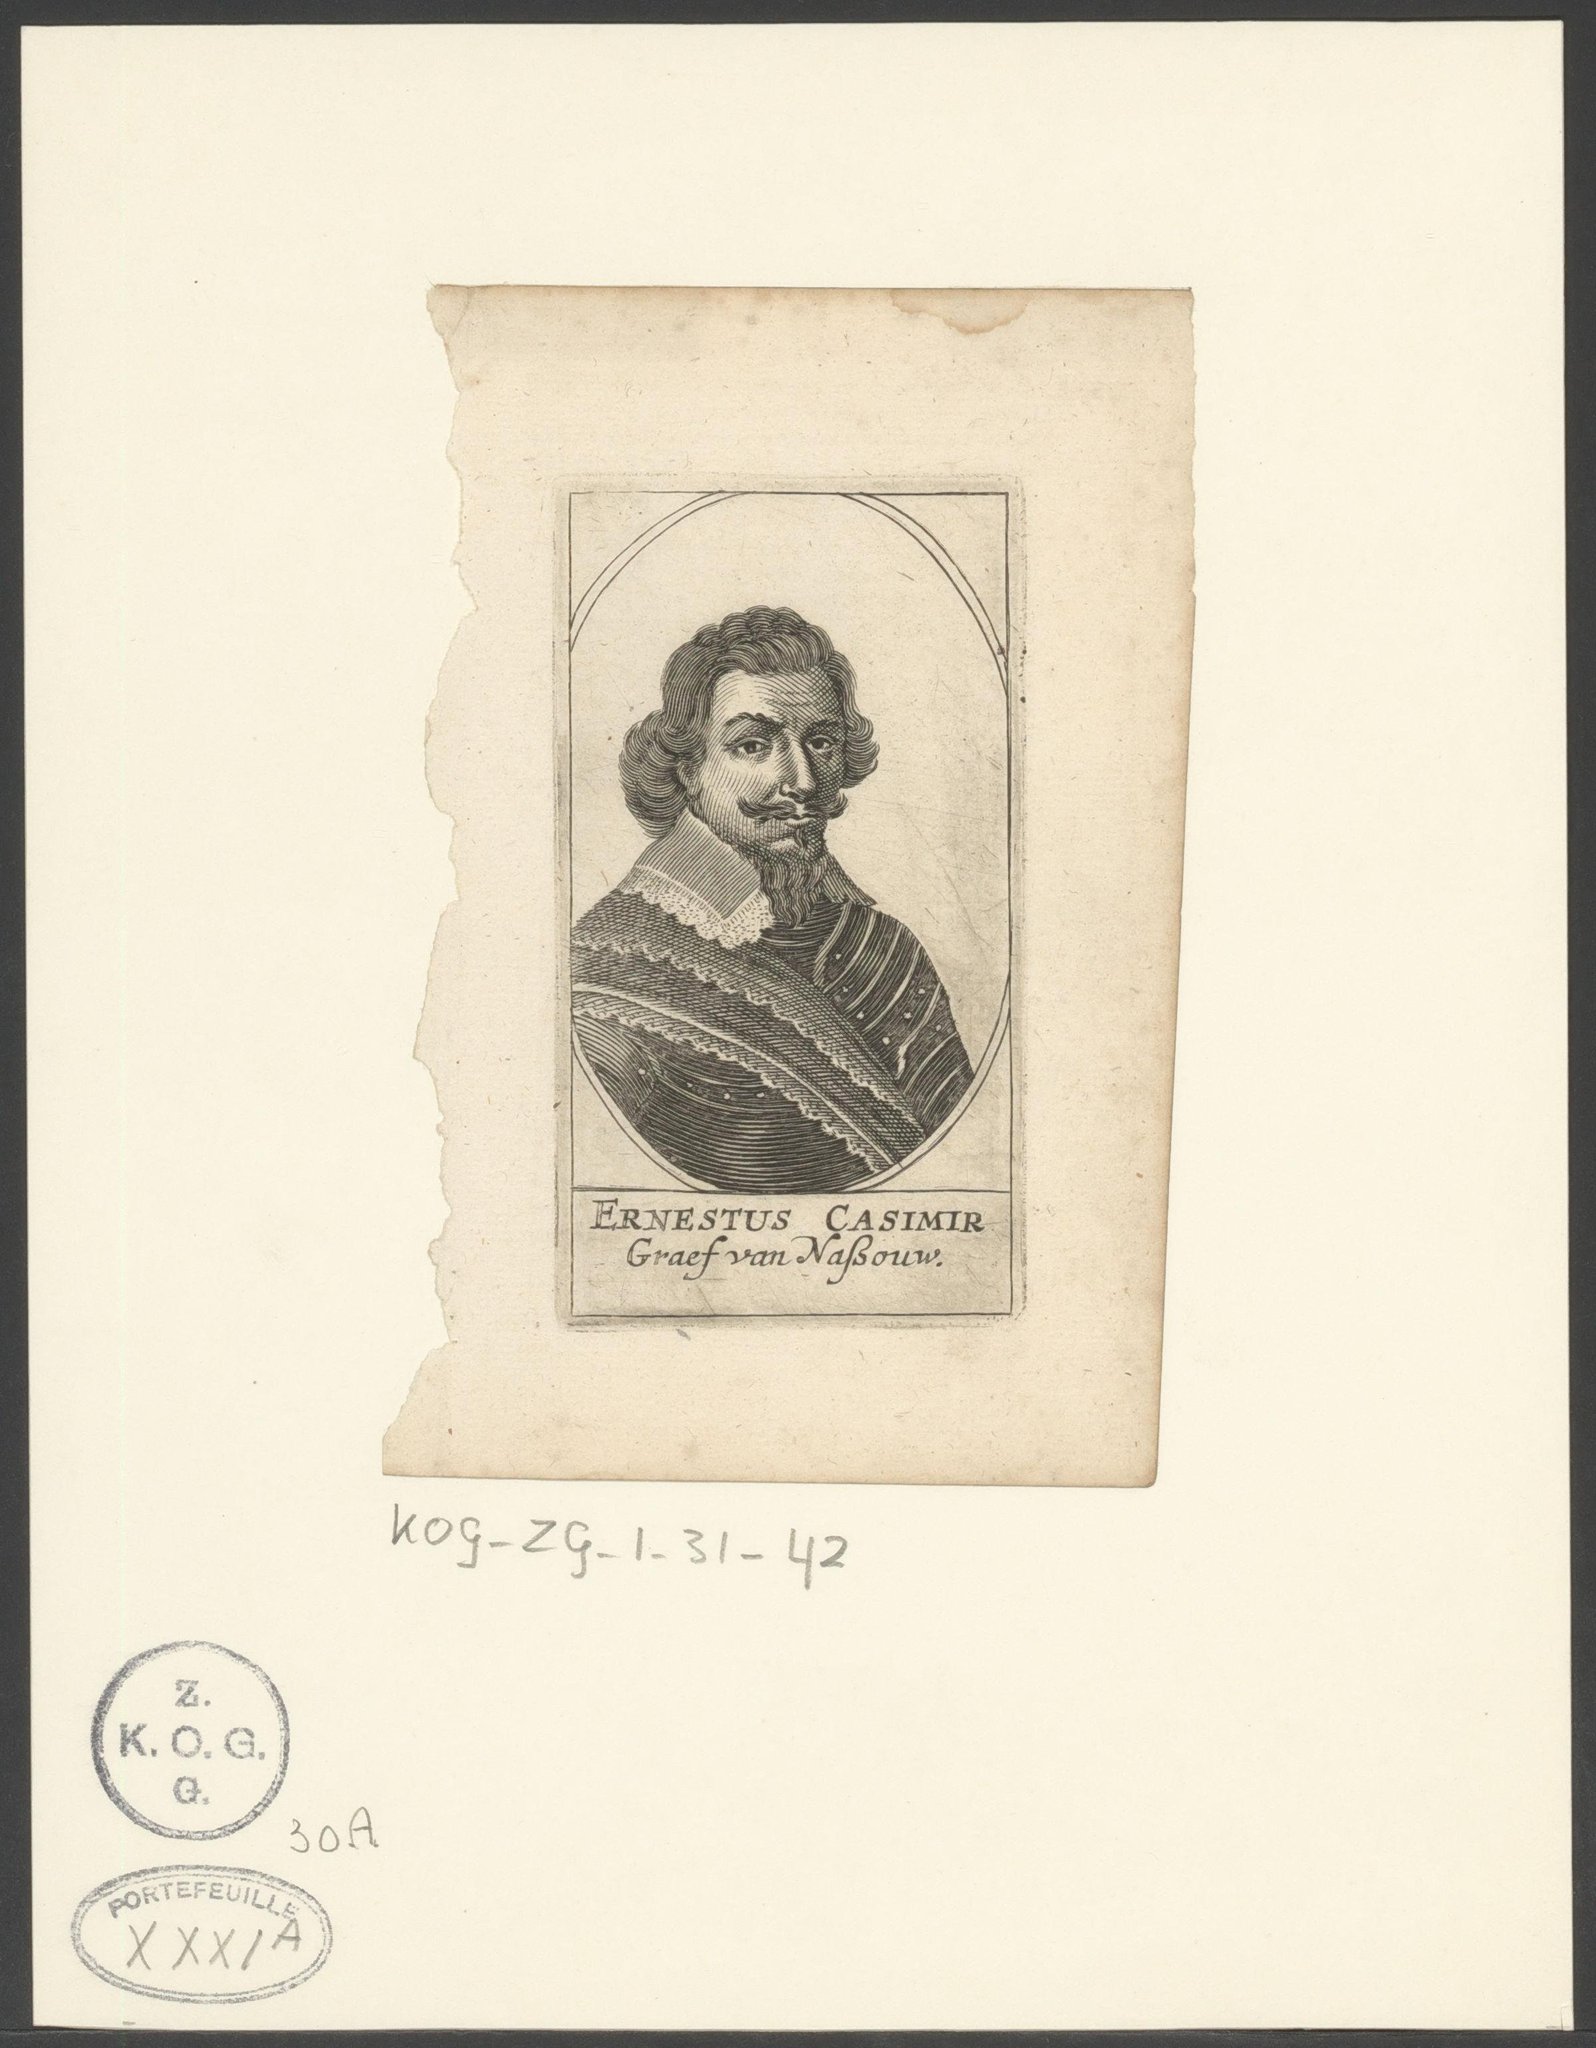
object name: print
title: Ernestus Casimir Graef van Naẞouw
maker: Anonymous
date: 1664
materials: paper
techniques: engraving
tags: historical persons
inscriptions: collector's mark: Lugt 1641, stamp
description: Prent waarschijnlijk uit: Montanus, Arnoldus. 't Leven en bedryf der Prinsen van Oranie: Wilhem de eerste, Maurits, Frederik Henrik, Wilhem de tweede, Wilhem de derde. Amsterdam: Arent van den Heuvel en Samuel Imbrecht, 1664. Eerdere staat gebruikt in: Montanus, Arnoldus. 't Vermeerderde leven en bedryf van Frederik Hendrik, prinse van Oranjen. Amsterdam: Cornelis Jansz. 1653.